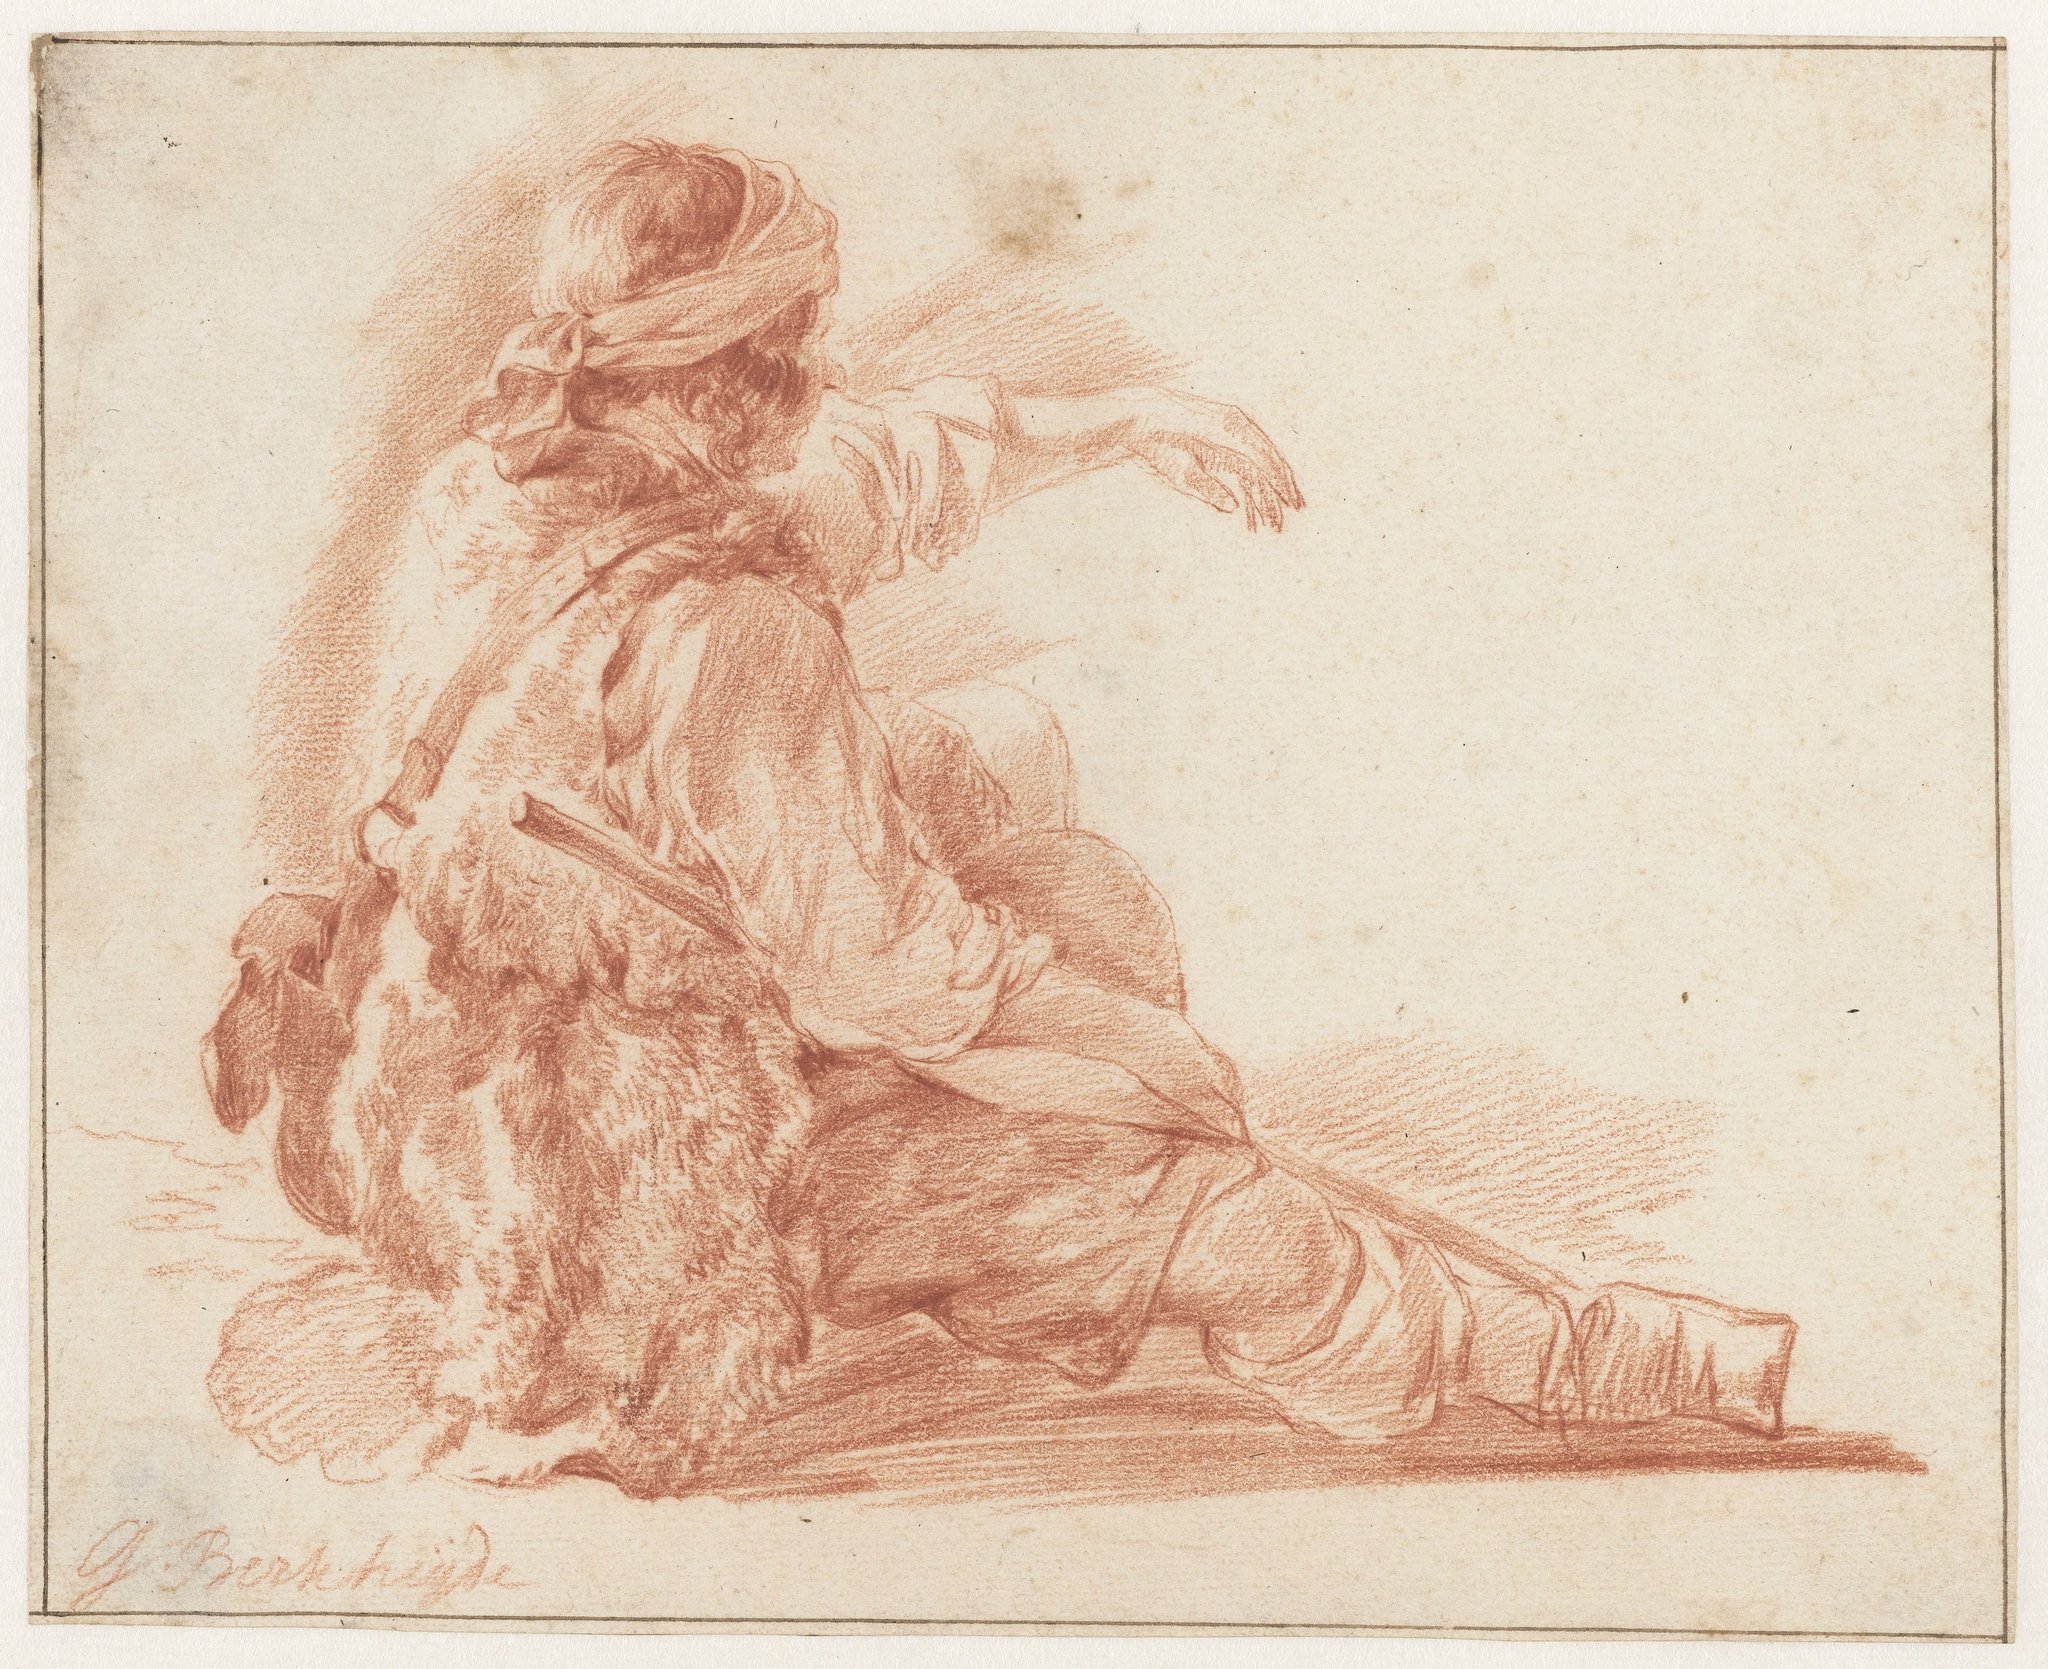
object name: drawing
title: Seated Shepherd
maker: gerrit berckheyde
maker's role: draughtsman, painter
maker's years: 1638-1698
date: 1648-1698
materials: chalk, paper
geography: haarlem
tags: sitting figure, herding, herdsman, herdswoman, shepherd, shepherdess, cowherd, etc.